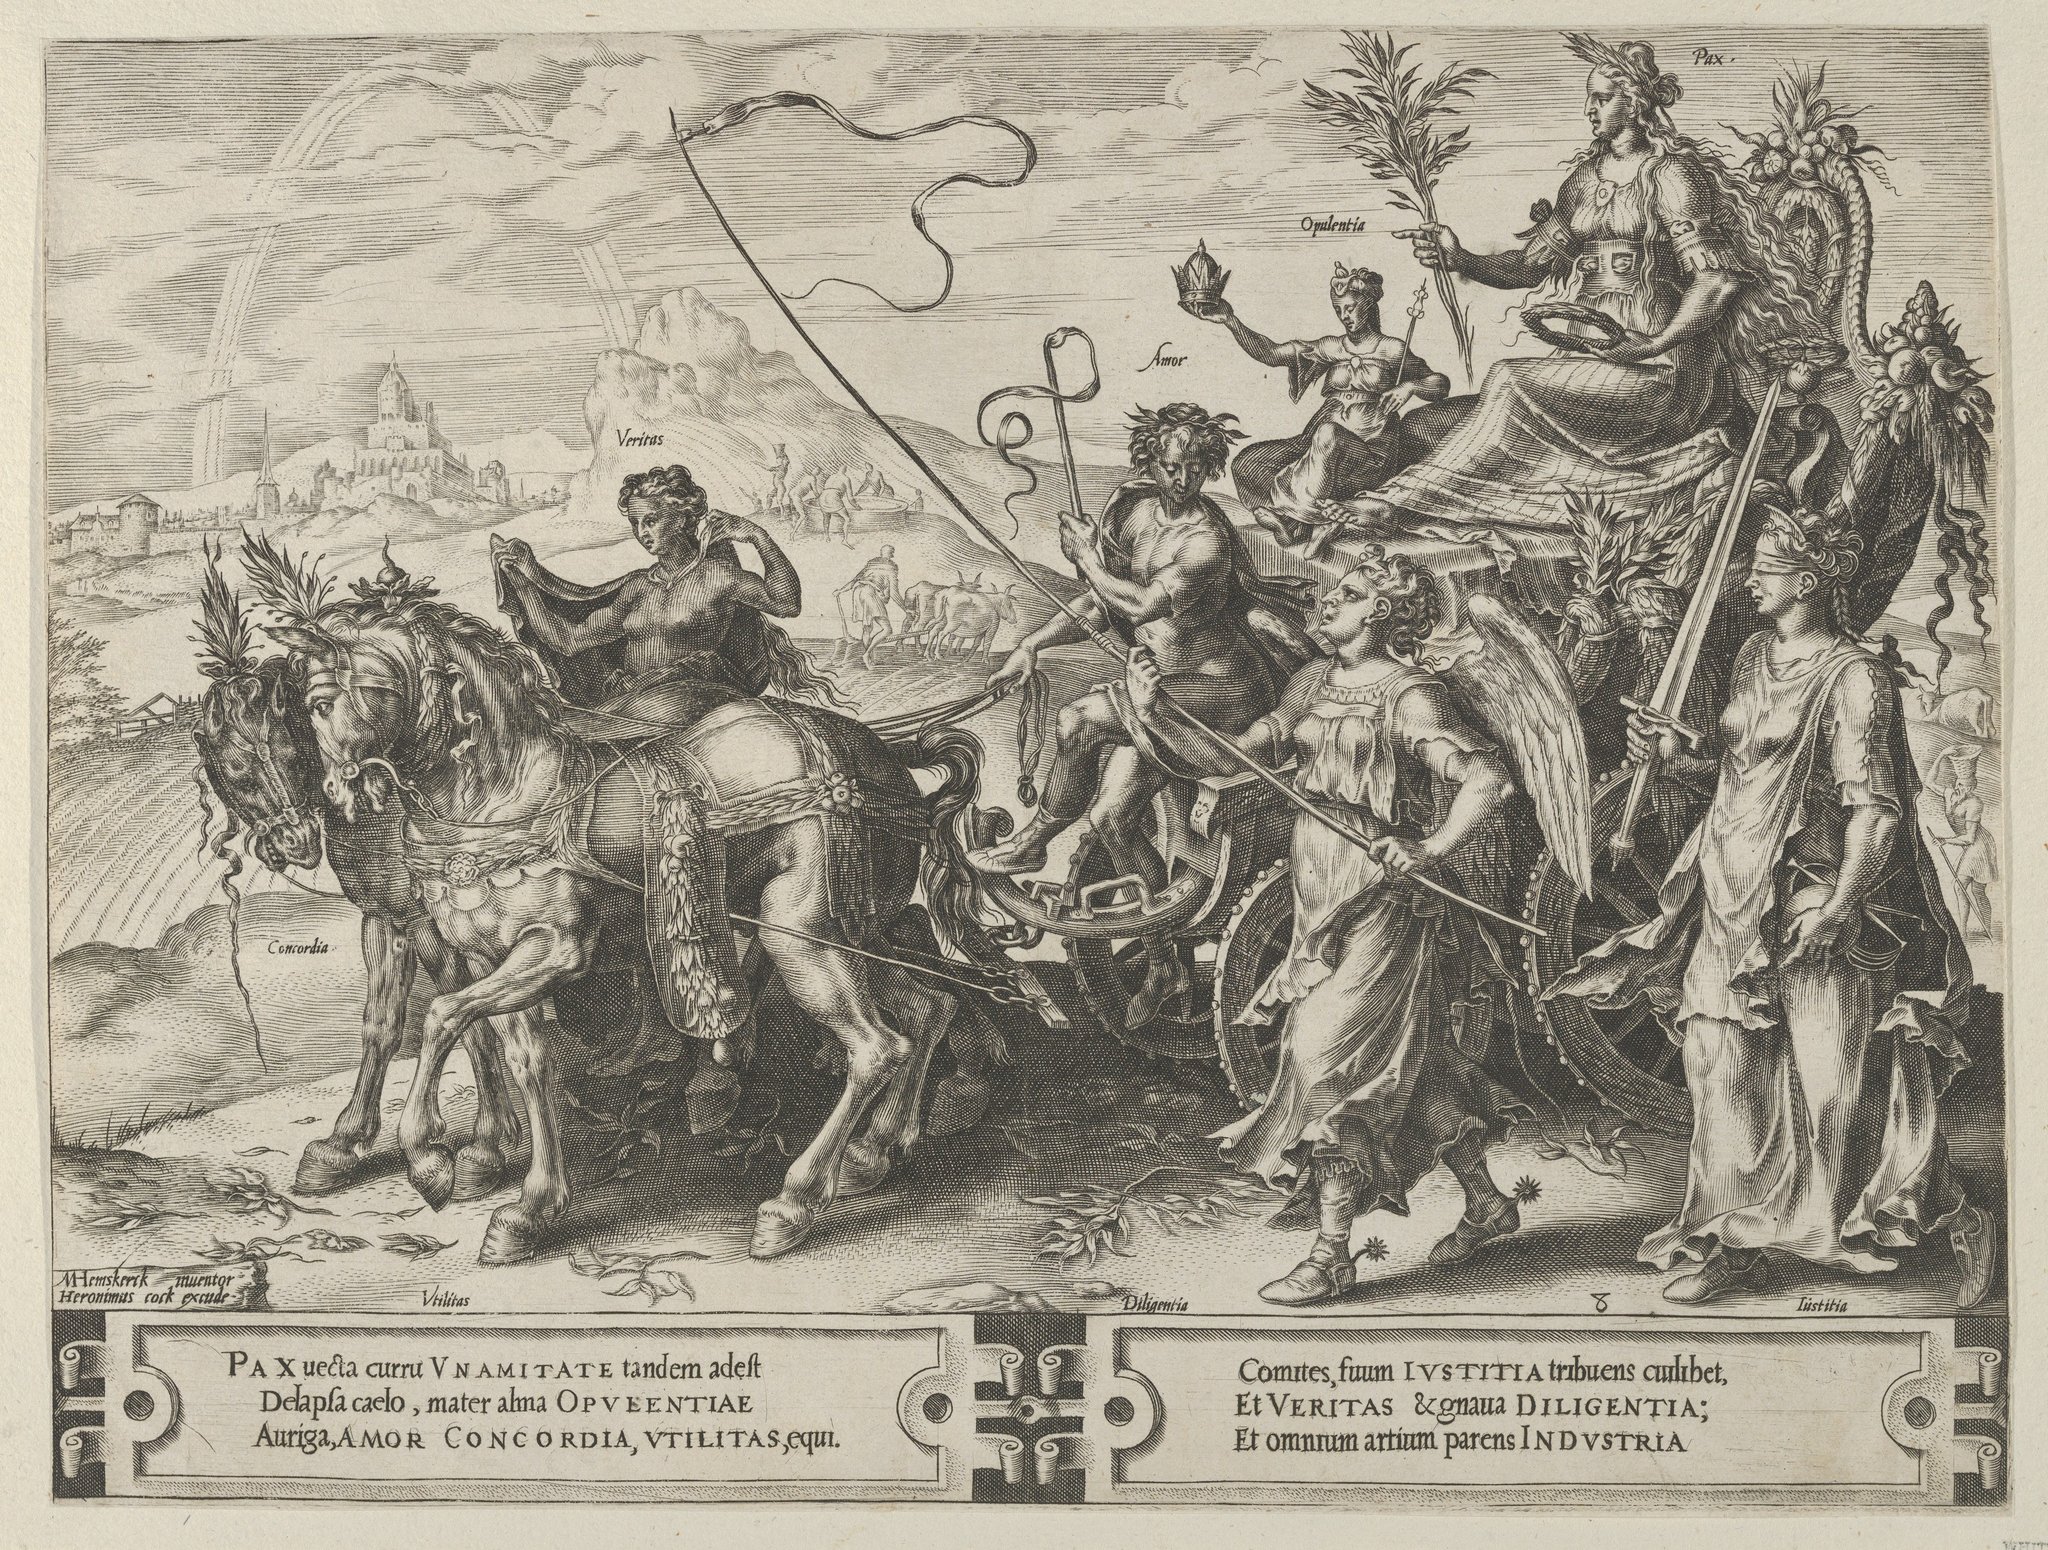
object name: print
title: The Triumph of Peace, from The Cycle of the Vicissitudes of Human Affairs, plate 8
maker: cornelis cort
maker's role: artist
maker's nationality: netherlandish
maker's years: 1533-1578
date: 1564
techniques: engraving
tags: men,women,horses,chariots